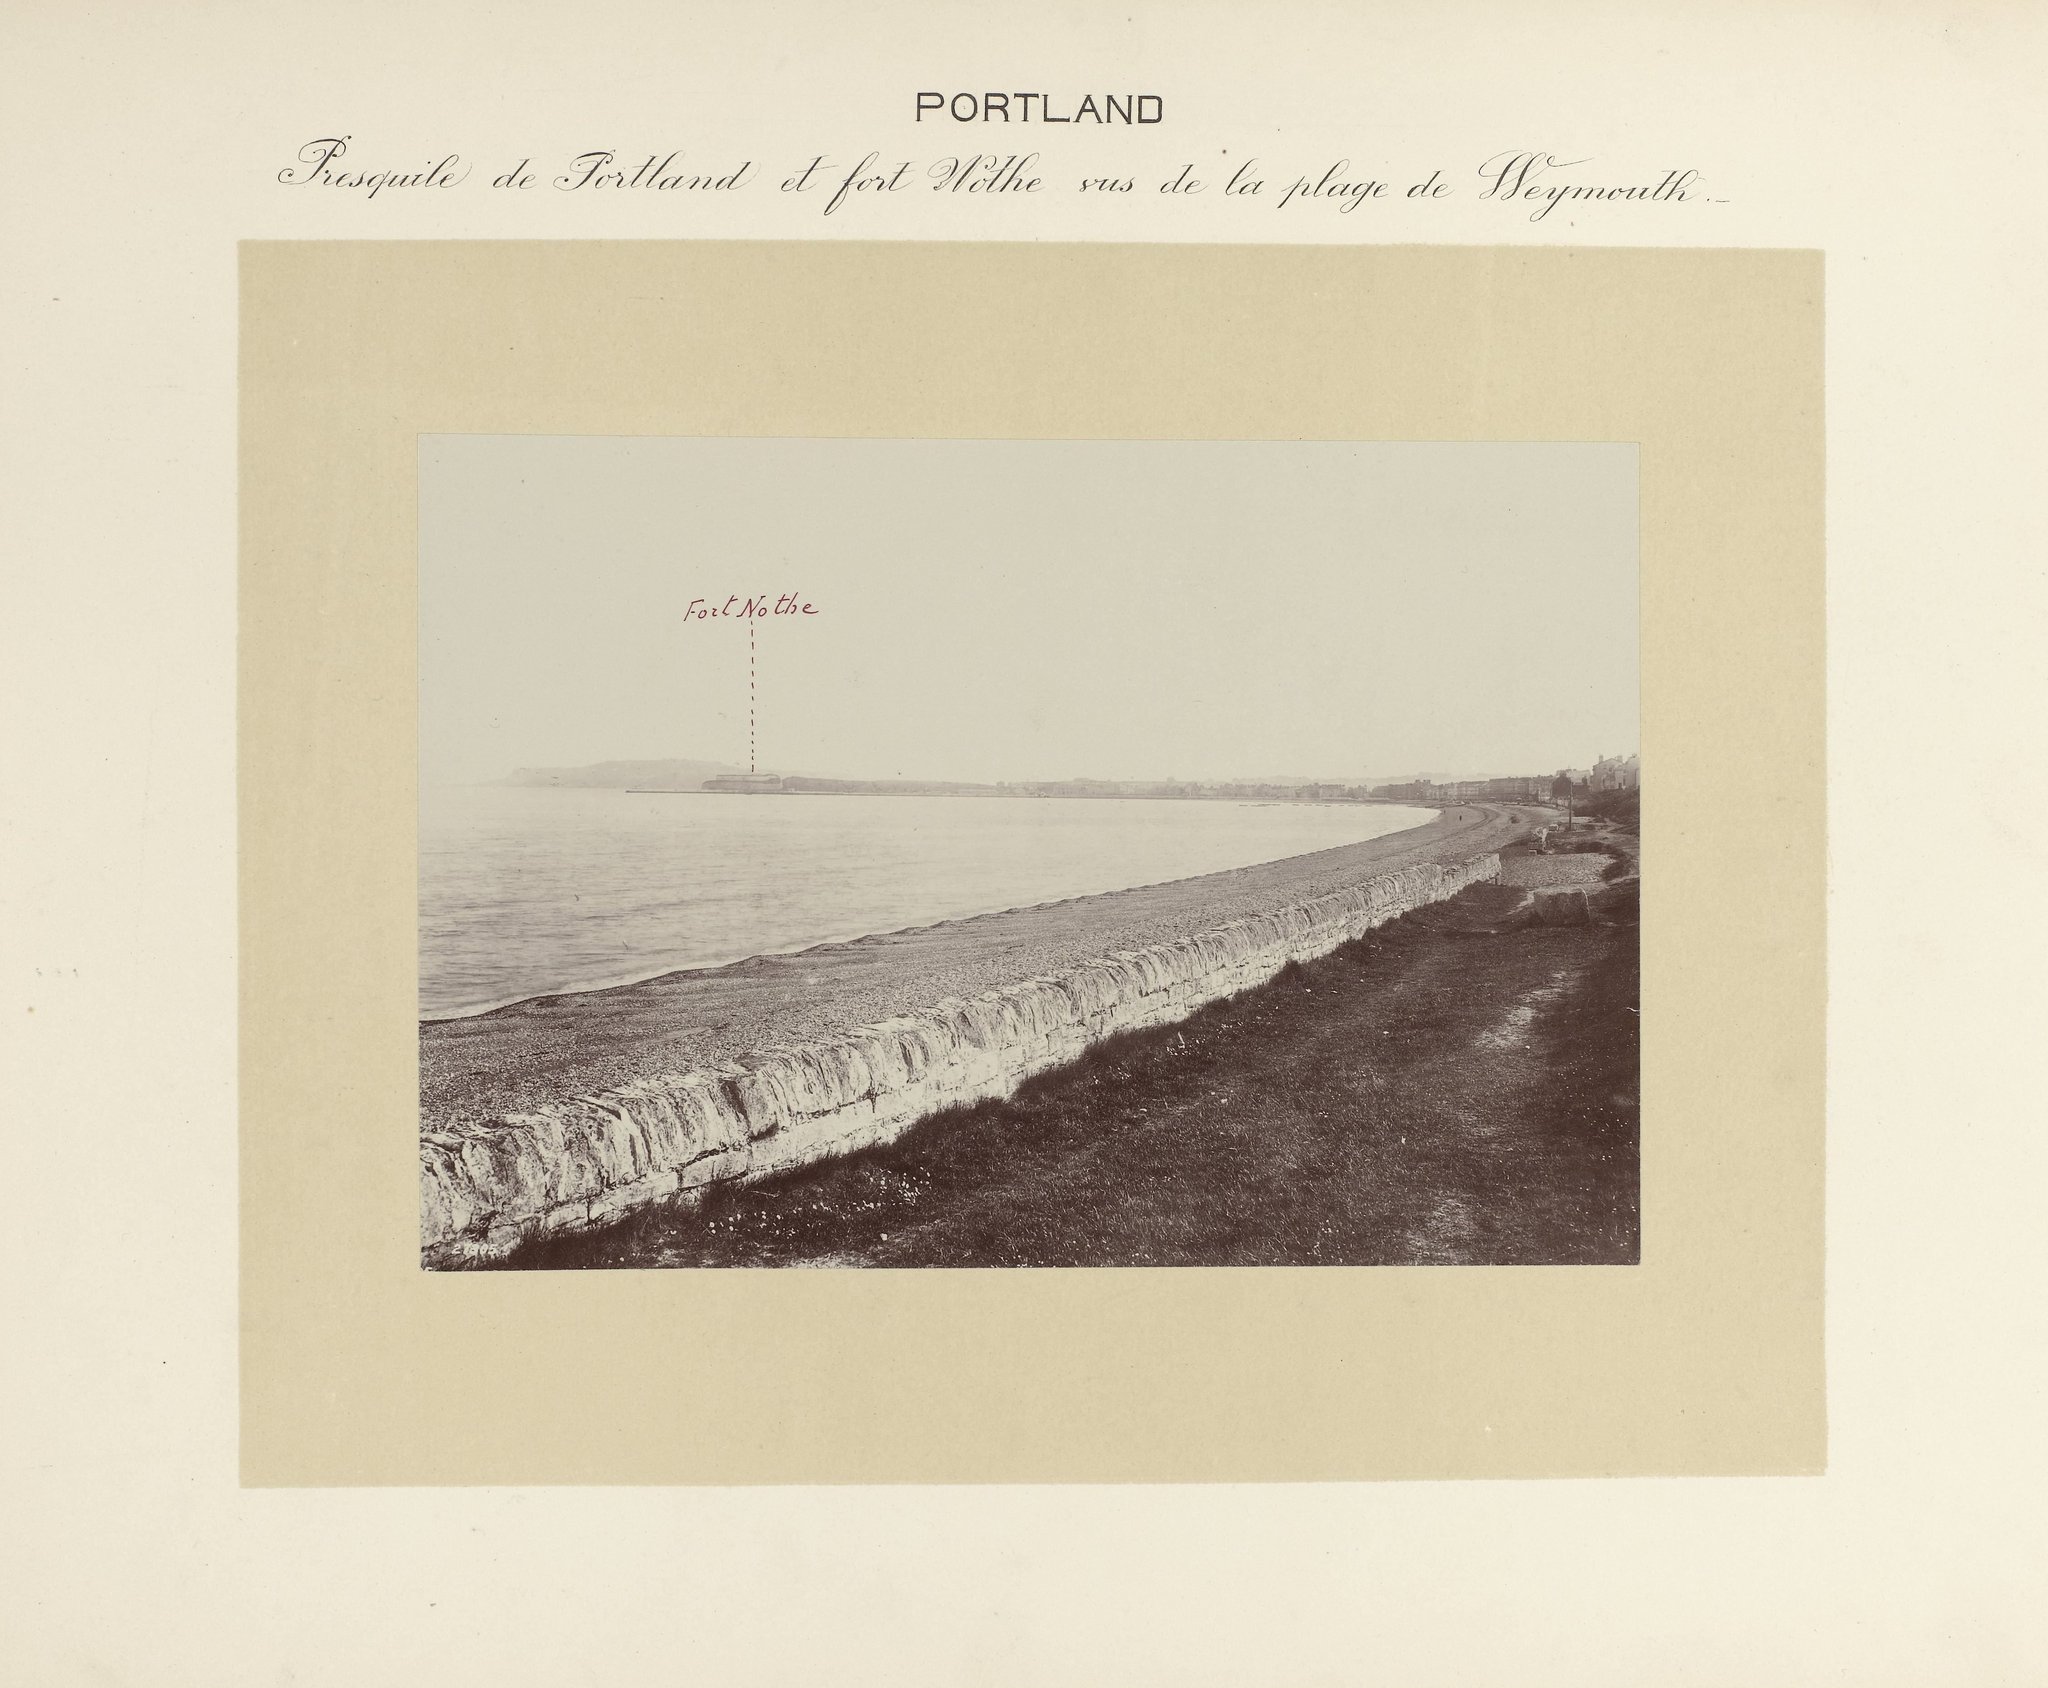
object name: photograph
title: Gezicht op het schiereiland van Portland en op fort Nothe, gezien vanaf het strand van Weymouth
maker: Anonymous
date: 1891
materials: cardboard, paper, photographic support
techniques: albumen print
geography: great britain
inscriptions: annotation: ‘Fort Nothe’, number: ‘27305’, inscription: ‘PORTLAND / Presquile de Portland et fort Nothe vus de la plage de Weymouth’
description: Foto uit een album met 35 topografische foto's van Britse kustplaatsen, waarop in pen militaire verdedigingswerken zijn aangegeven door een Franse militair.